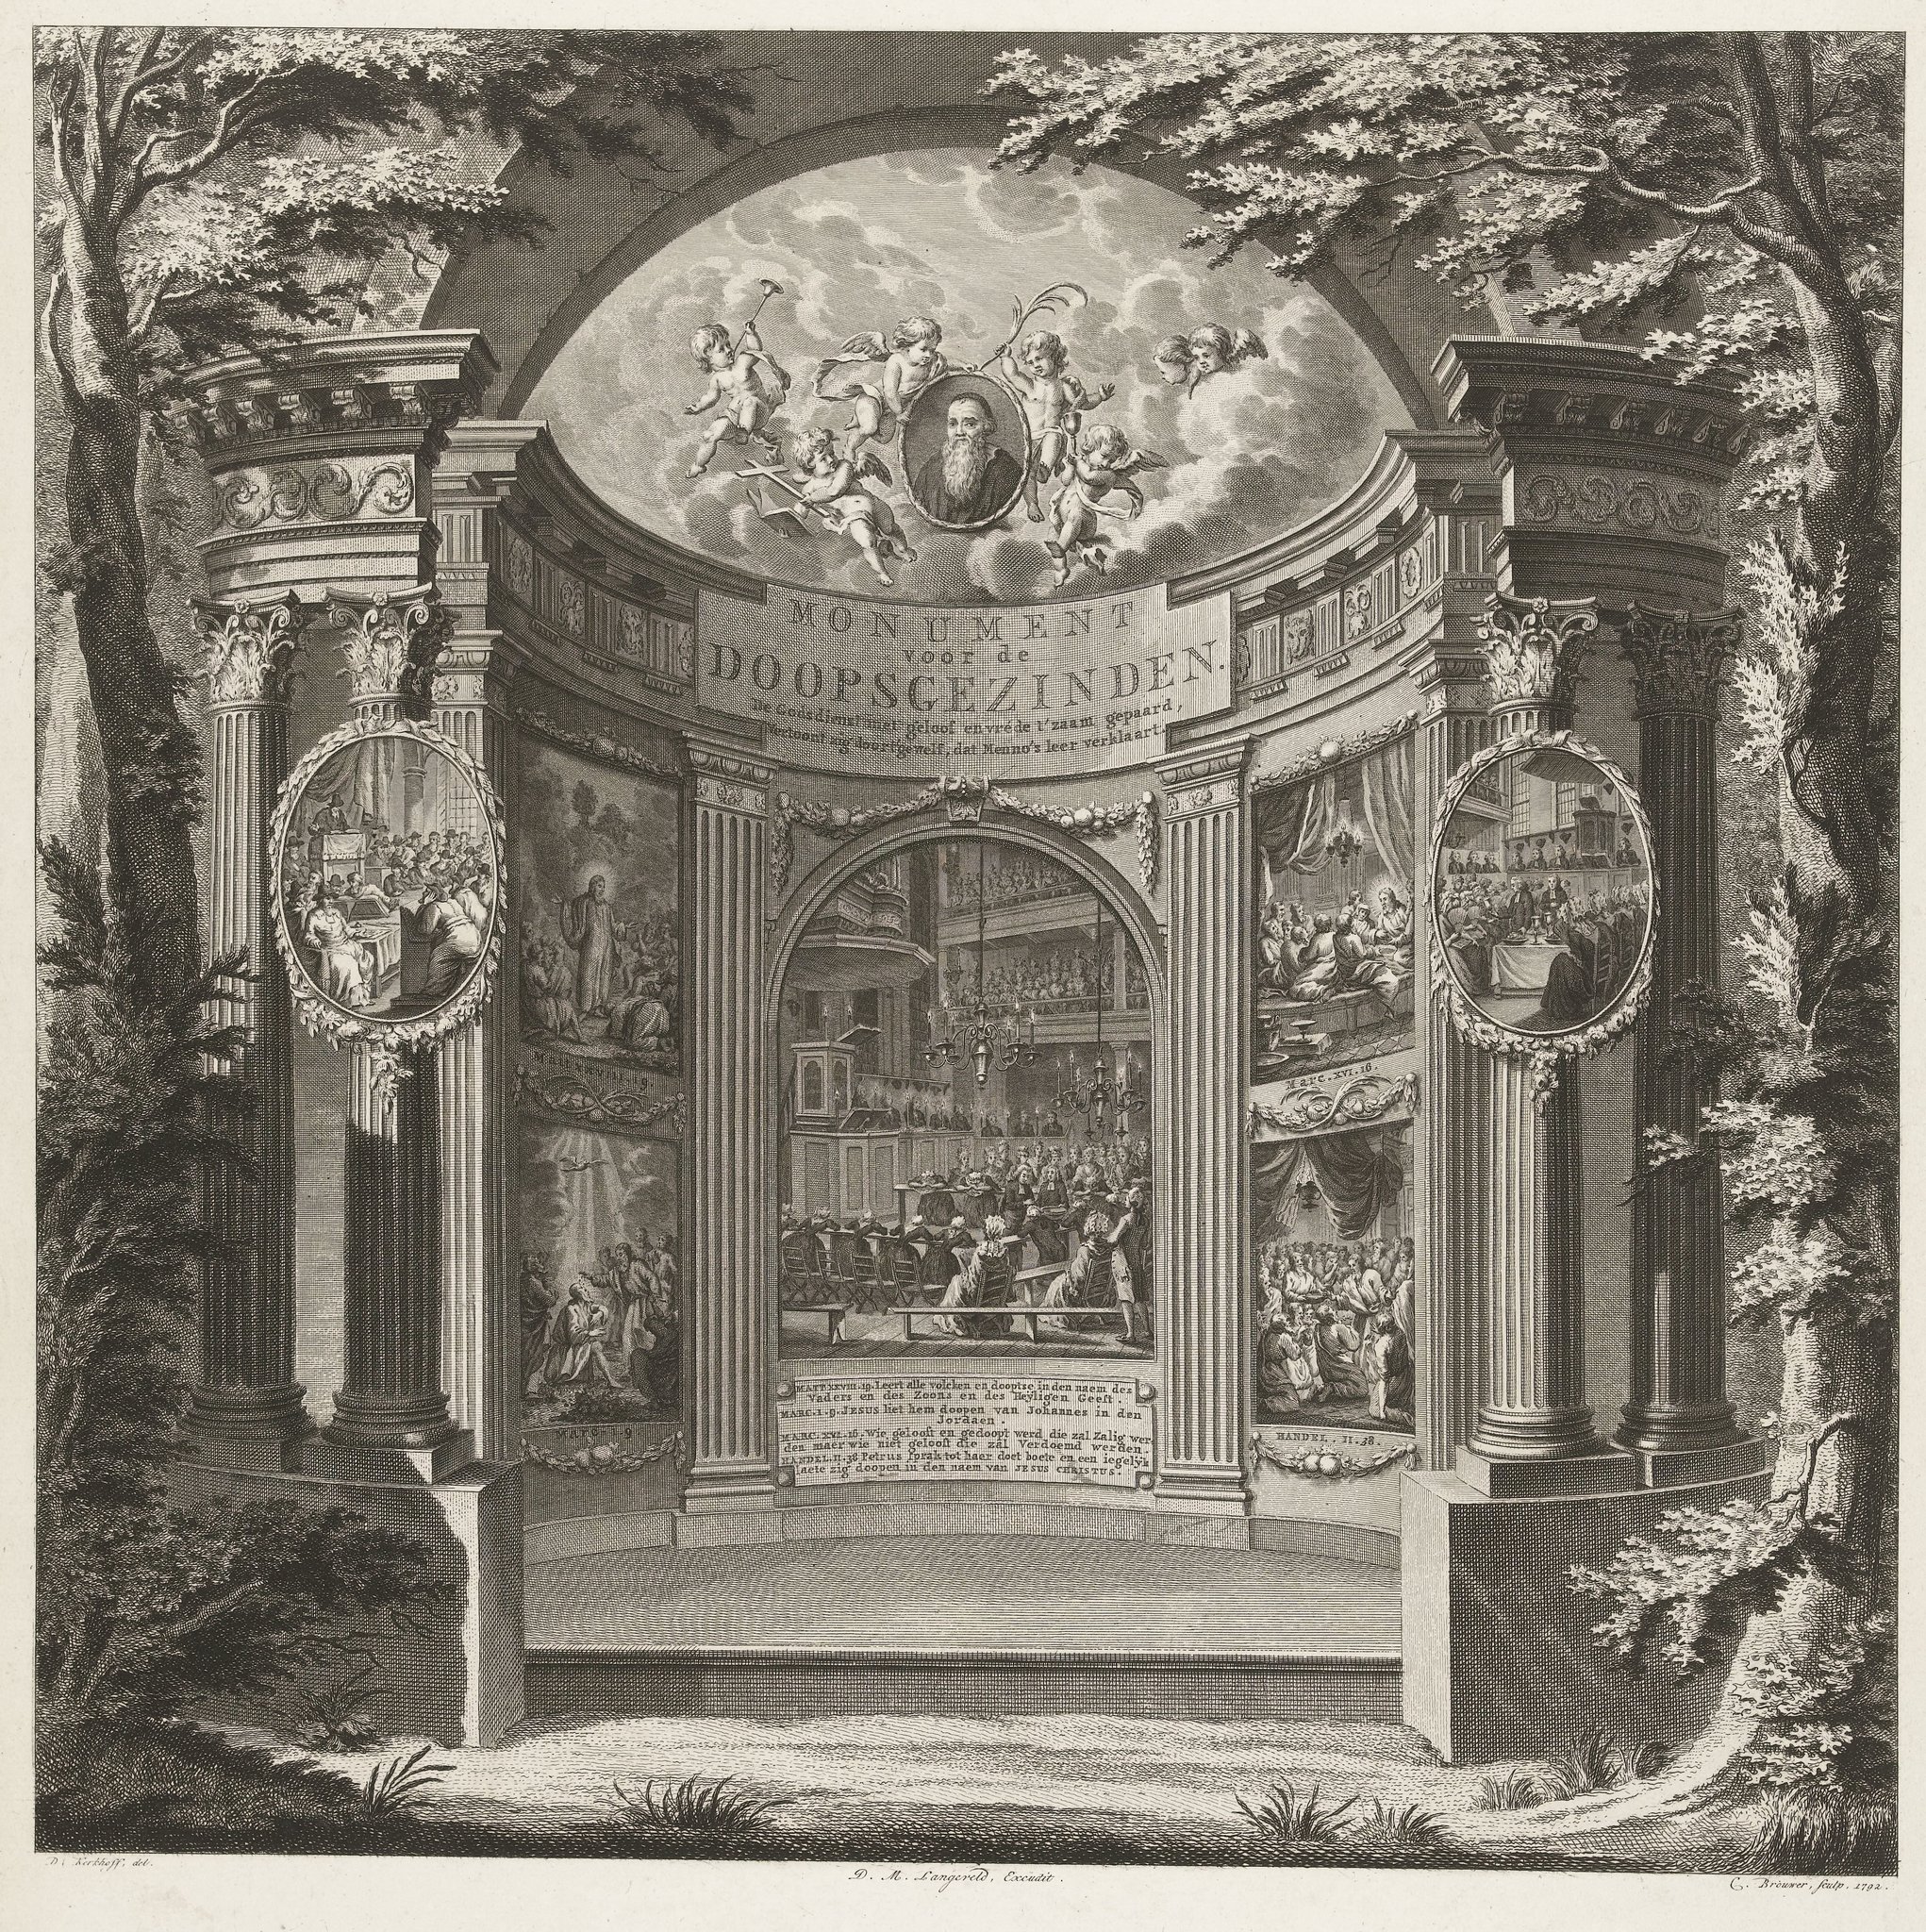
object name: print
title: Monument voor de Doopsgezinden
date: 1792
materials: paper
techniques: engraving, etching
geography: amsterdam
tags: clergyman, protestant churches and denominations, interior of church, monument, statue, preaching (in general), communion ~ holy mass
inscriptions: date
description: Een monument voor de doopsgezinde gemeente. In het midden tussen de pilaren een afbeelding van een doopsgezinde kerkdienst. Aan weerszijden vier bijbelscènes. In de koepel van het monument een medaillon met het portret van Menno Simons . Op de zuilen van het monument twee medaillons met belangrijke elementen uit de doopsgezinde leer: links de preek en rechts het avondmaal.